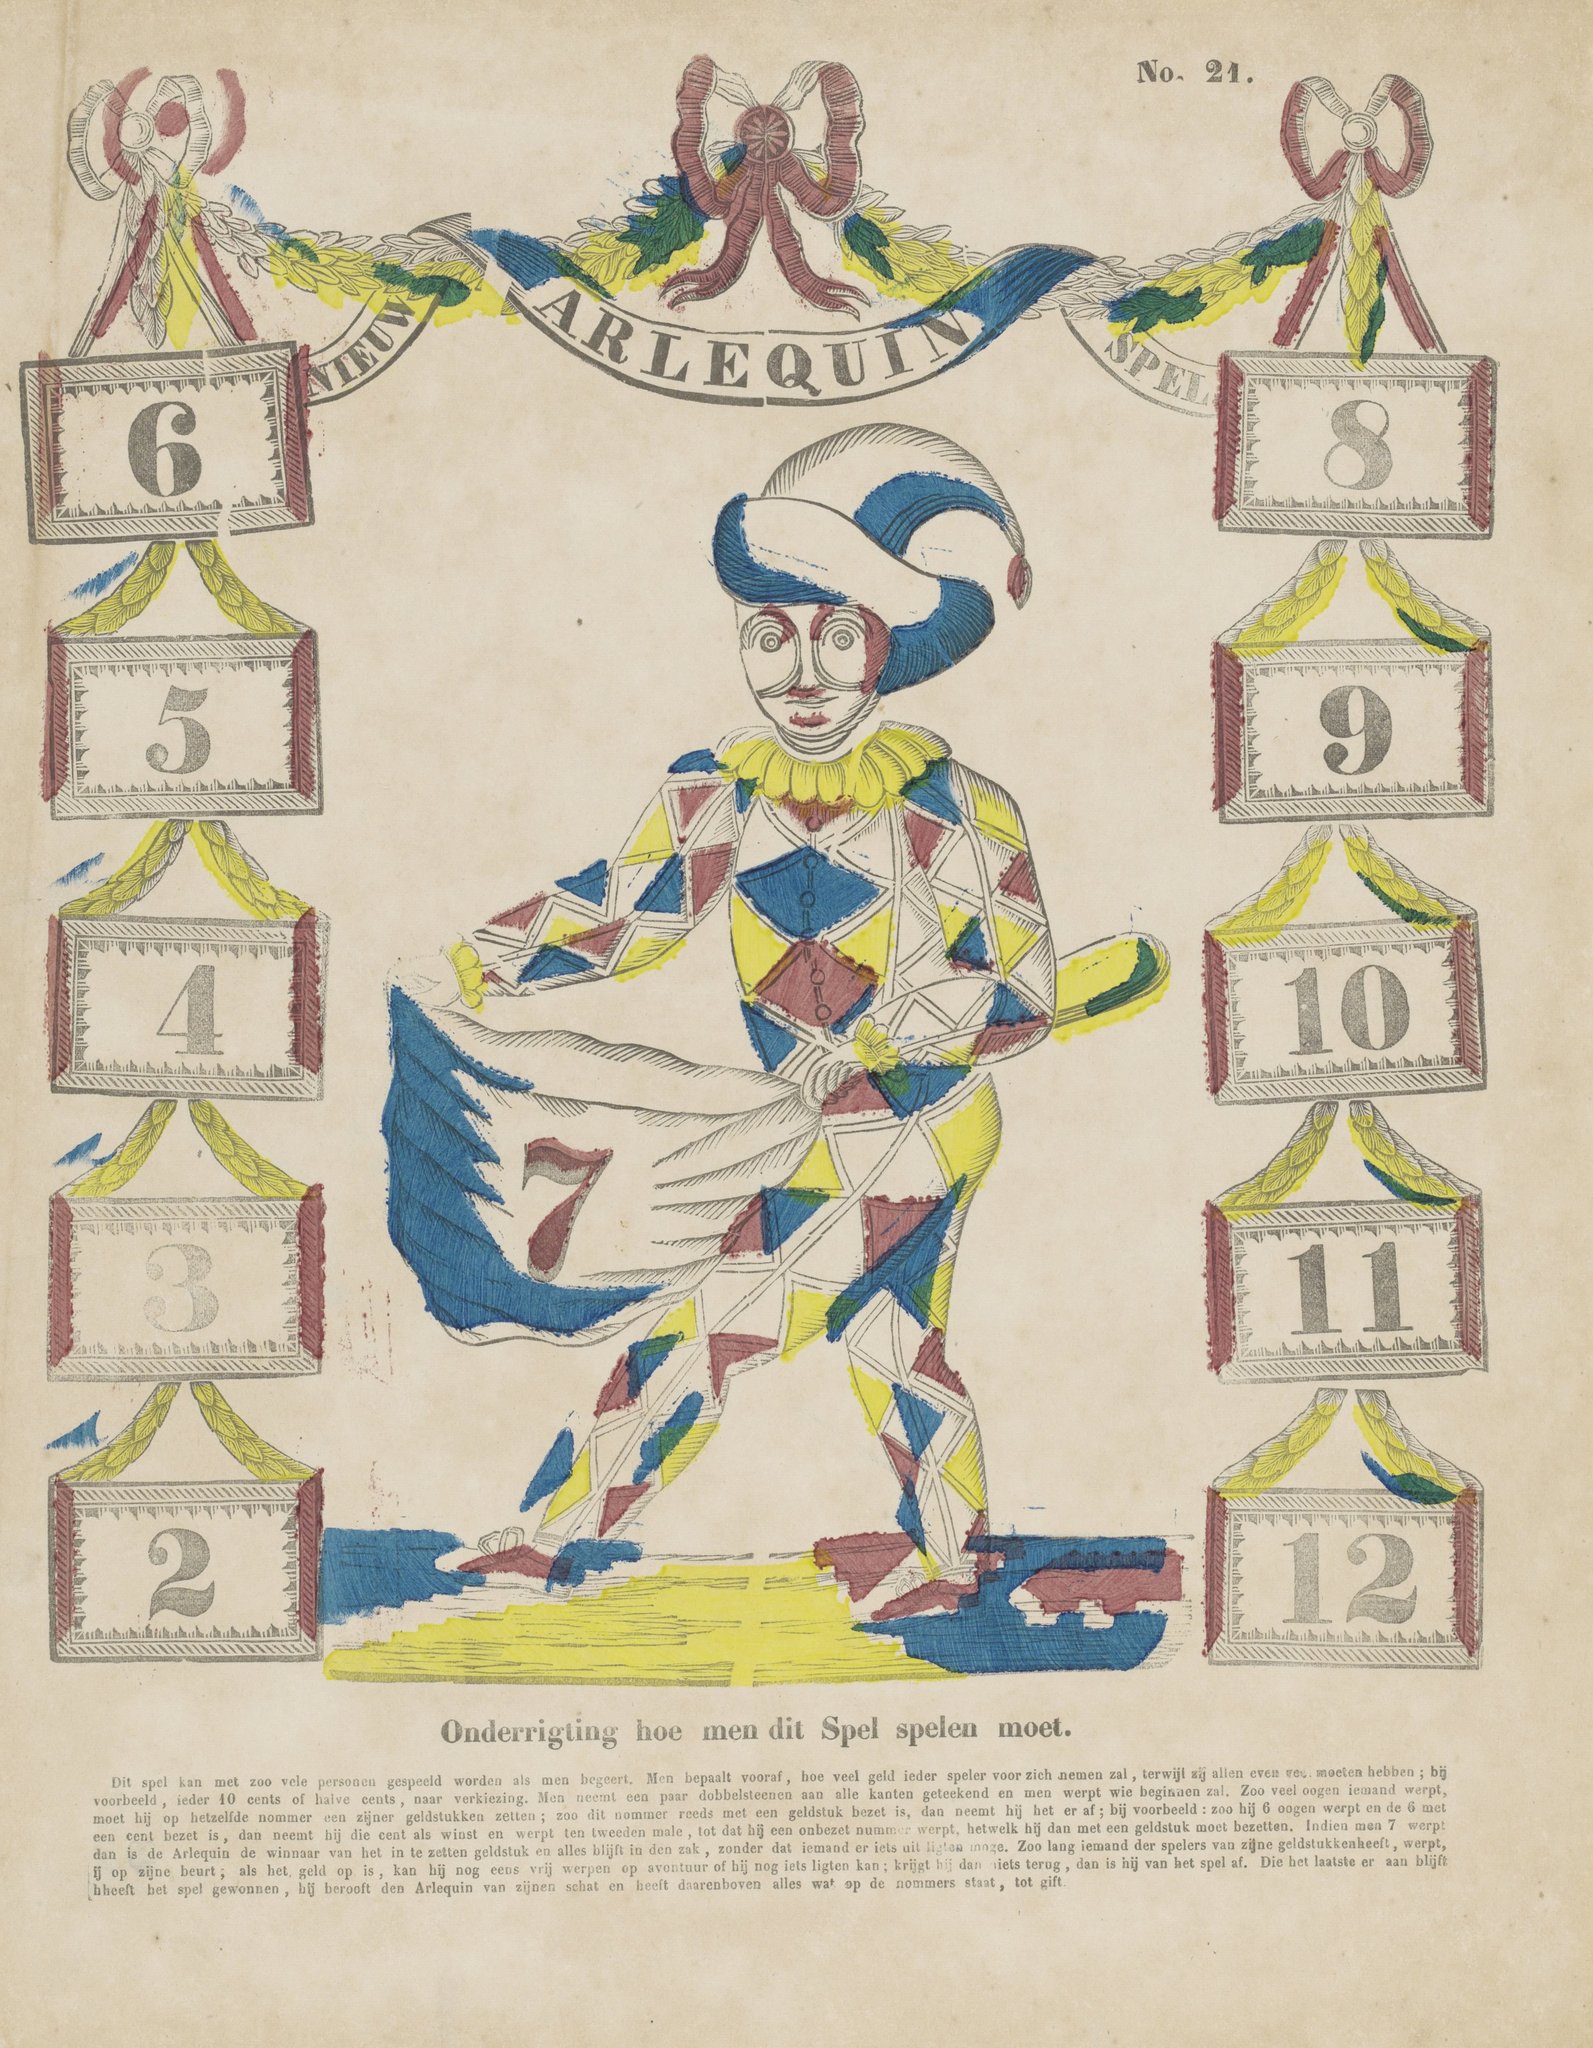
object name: print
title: Nieuw Arlequin spel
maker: Anonymous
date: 1848-1881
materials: paper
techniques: colour, letterpress printing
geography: den bosch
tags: board-games of chance, types in 'commedia dell'arte': harlequin, board-games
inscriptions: collector's mark: Lugt 2760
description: Bordspel met in het midden van het speelveld een harlekijn die in zijn geopende handen een zak houdt met daarop het cijfer 7. Rondom hem een guirlande waaraan medaillons hangen met de cijfers 2 tot en met 12. In de ondermarge de spelregels in boekdruk. Genummerd rechtsboven: No. 21.